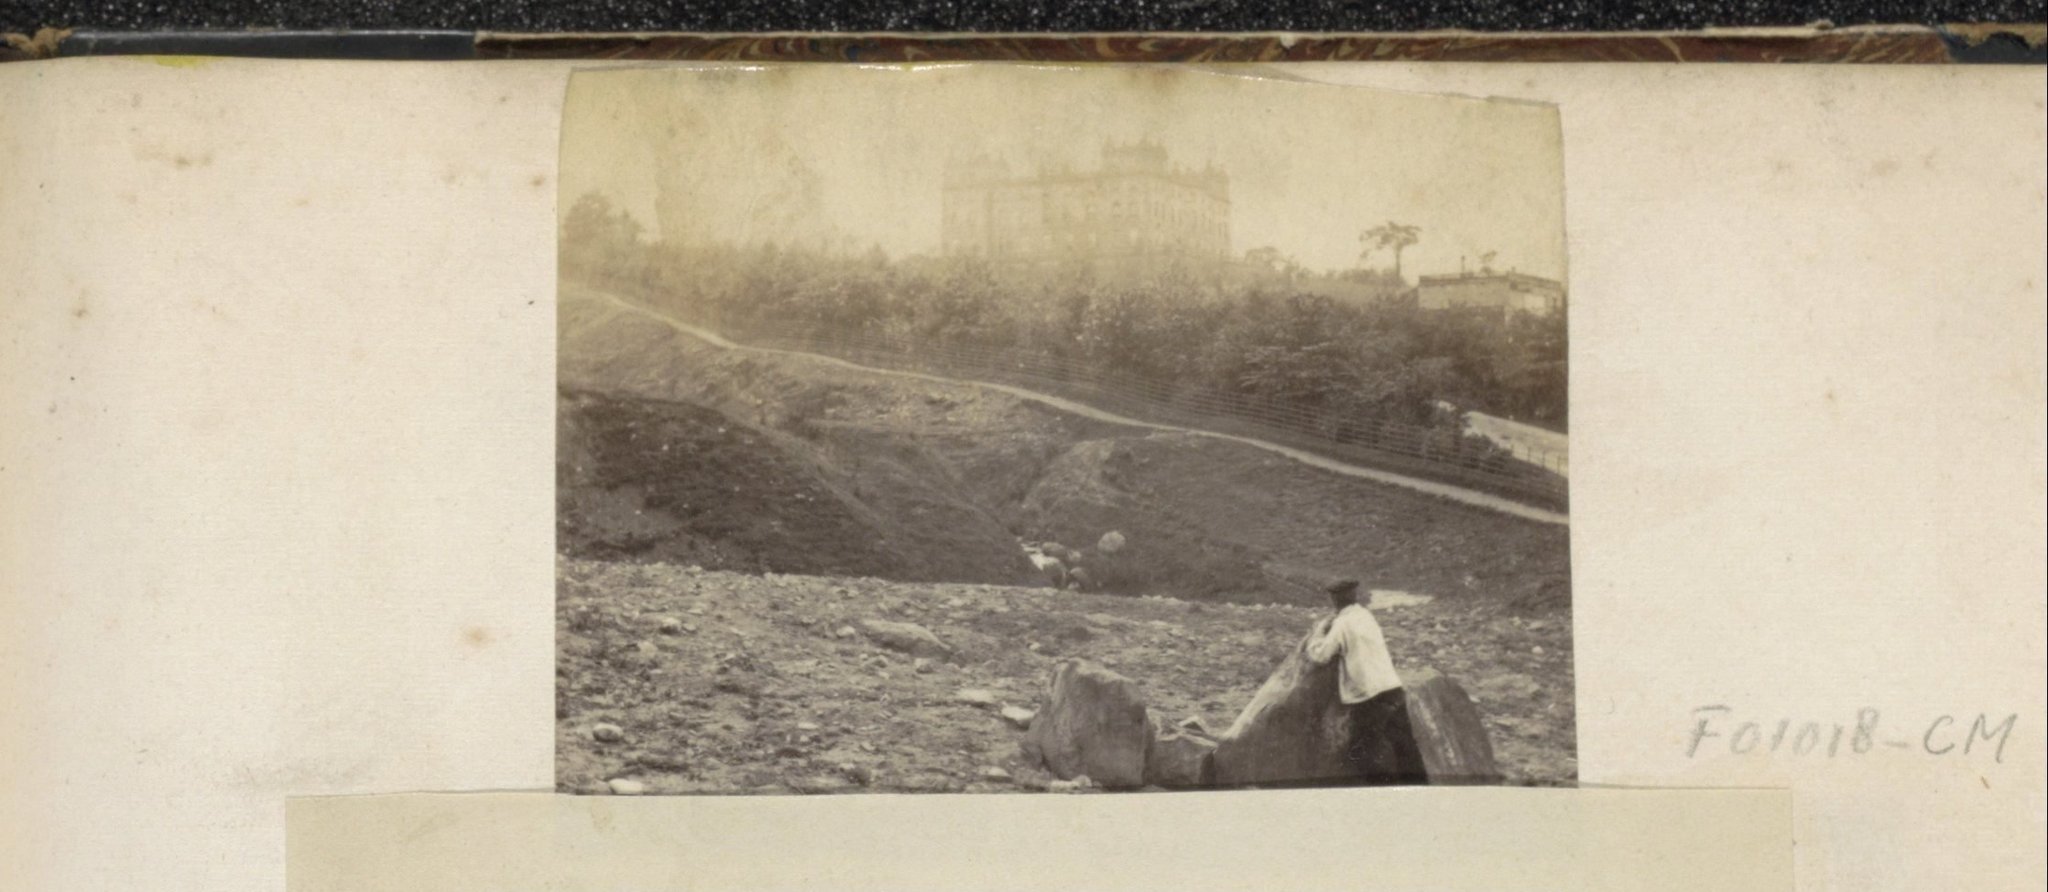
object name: photograph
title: Gezicht op een kasteel met een figuur op de voorgrond, vermoedelijk in England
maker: Anonymous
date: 1860-1870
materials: paper, photographic support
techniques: albumen print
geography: england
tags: low hill country, standing figure, castle, england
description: Onderdeel van Engels familiealbum met foto's van personen, reizen, cricket en kunstwerken.